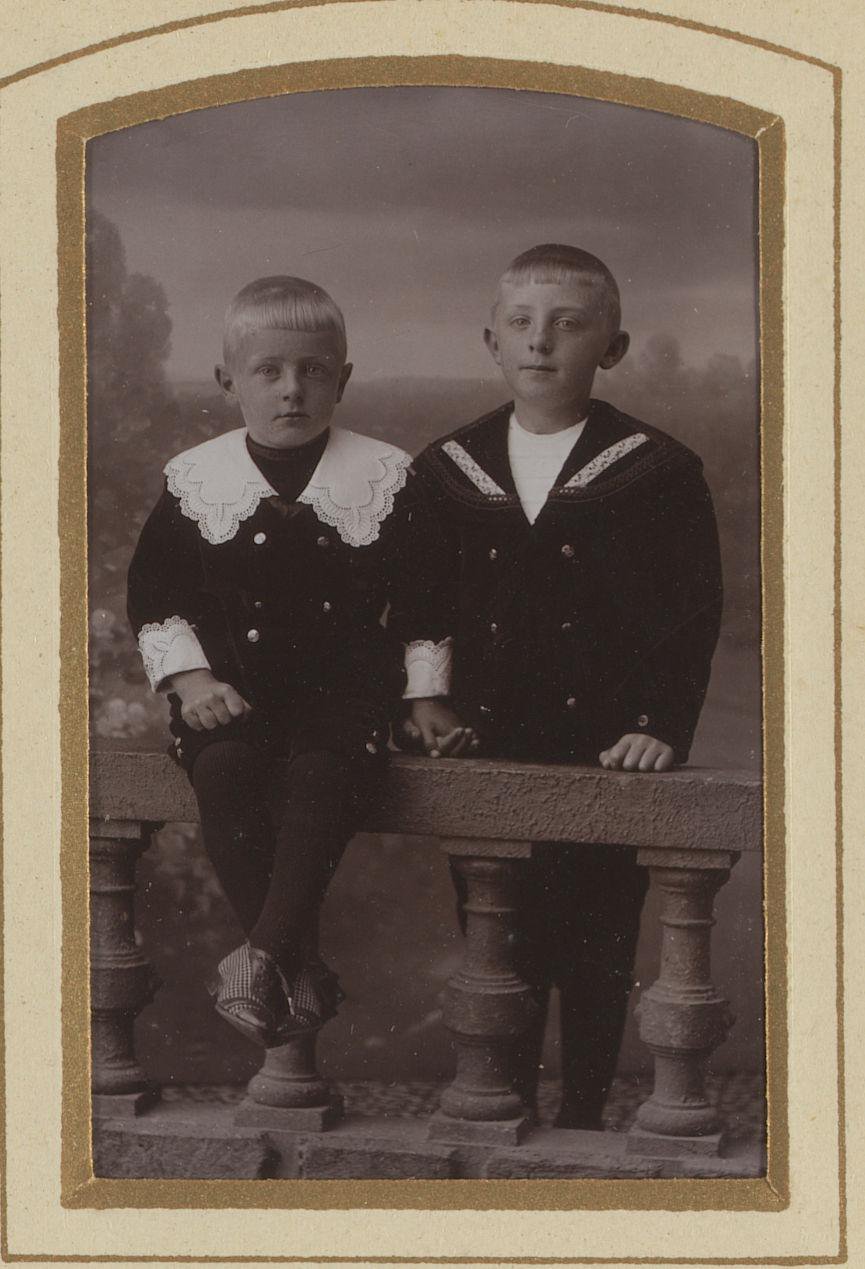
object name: carte de visite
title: Portret van een twee jongens bij een balustrade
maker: klaas schotsman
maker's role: fotograaf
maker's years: 1864-1931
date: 1890-1931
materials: cardboard, photographic support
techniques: collodion silver print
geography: edam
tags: boy (child between toddler and youth) (+ two persons), historical persons, balustrade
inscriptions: inscription: ‘K. Schotsman/ EDAM’